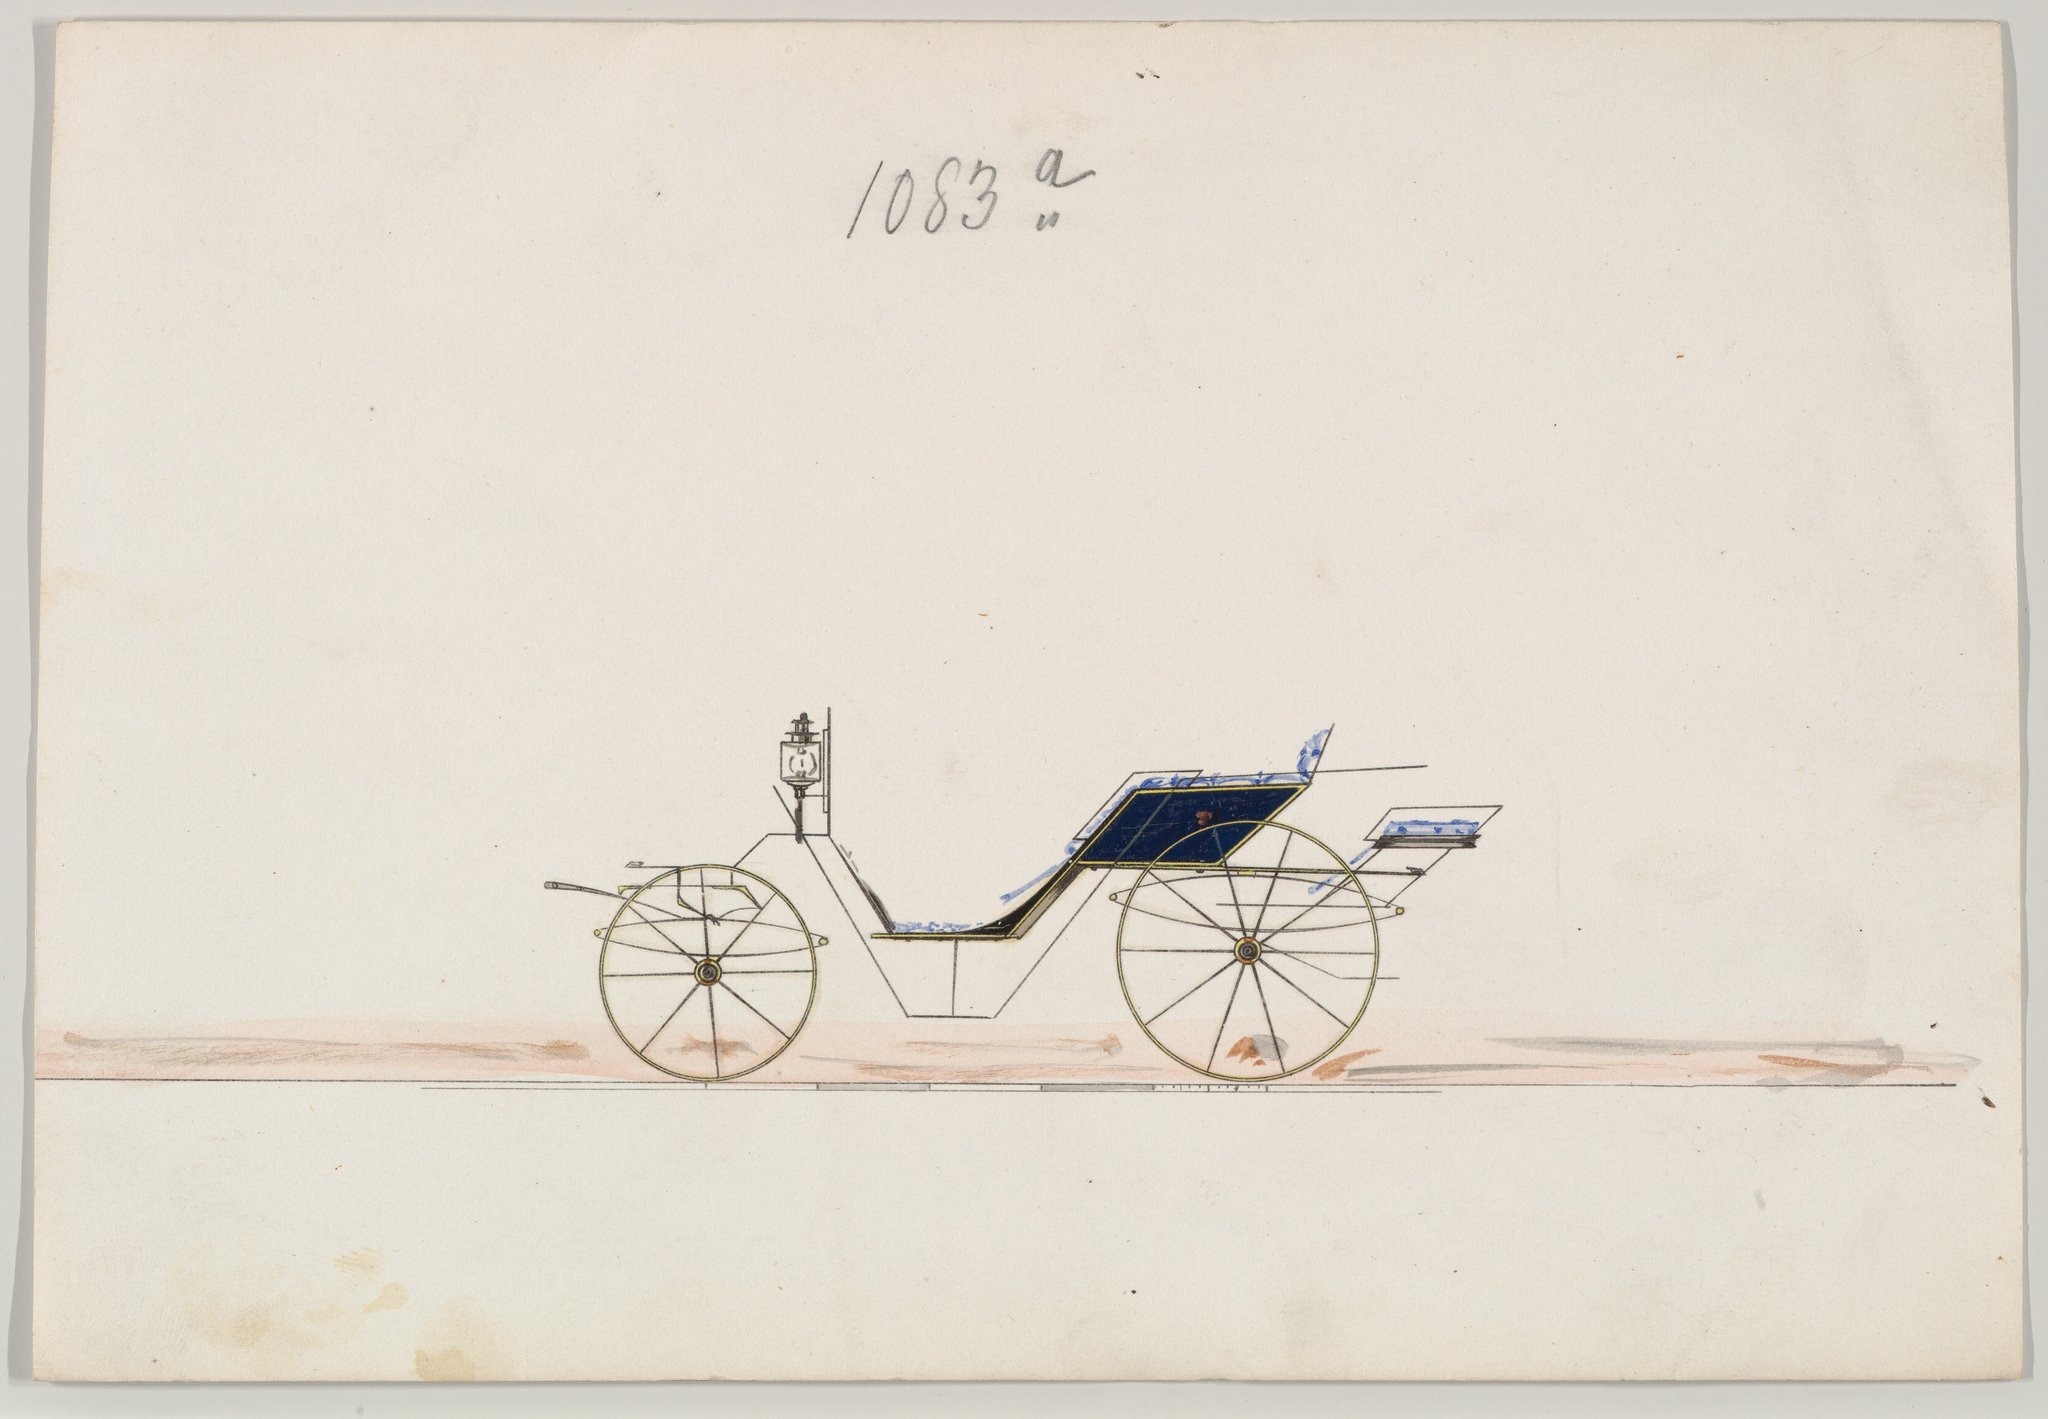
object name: drawing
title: Phaeton #1083a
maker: brewster & co.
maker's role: manufacturer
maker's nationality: american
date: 1870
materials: gouache, gum arabic, ink, watercolor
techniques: pen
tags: carriages